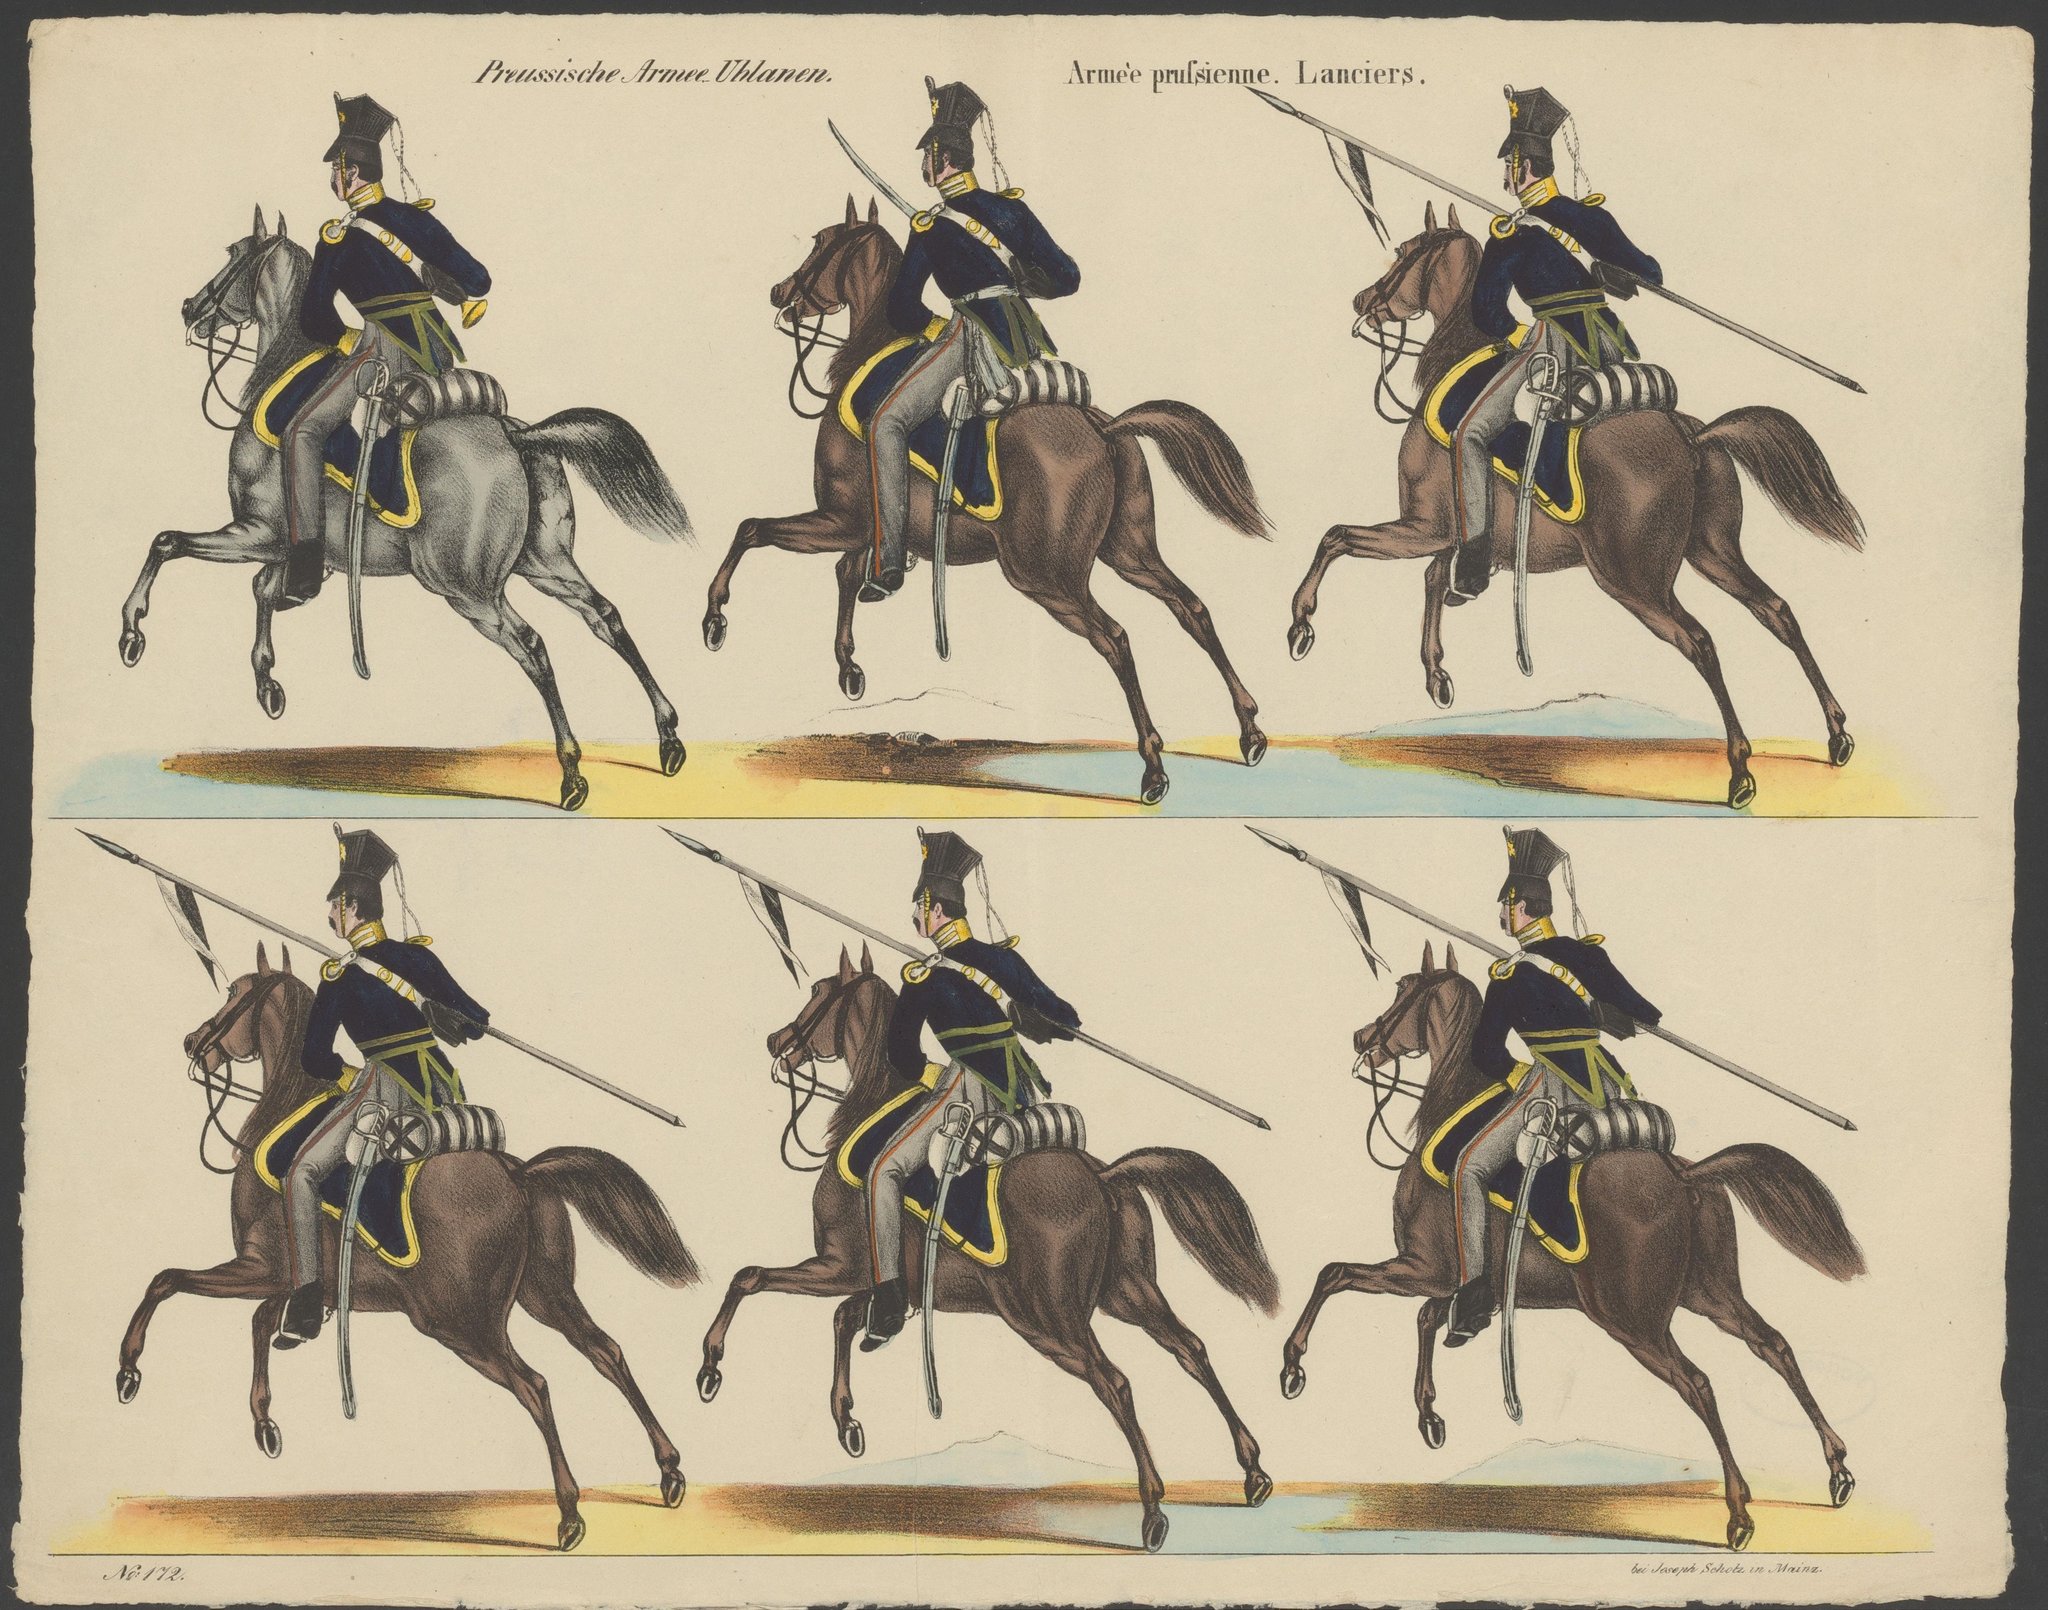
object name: print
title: Prussische Armee Uhlanen / Armeè prussienne. Lanciers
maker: Anonymous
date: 1829-1880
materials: paper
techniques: hand coloring, lithograph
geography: mainz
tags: the company, the unit, the troop ~ military service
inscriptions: stamp, collector's mark: Lugt 1641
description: Zes Pruisische ulanen in twee rijen. Linksonder genummerd: No. 172. Onderwerpsrubrieken binnen de Atlas Zeden en Gewoonten: Zeden en Gewoonten in Engeren Zin, Des menschen beging, midden en einde, Kinderleven – Kinderspel en Kinderprenten.